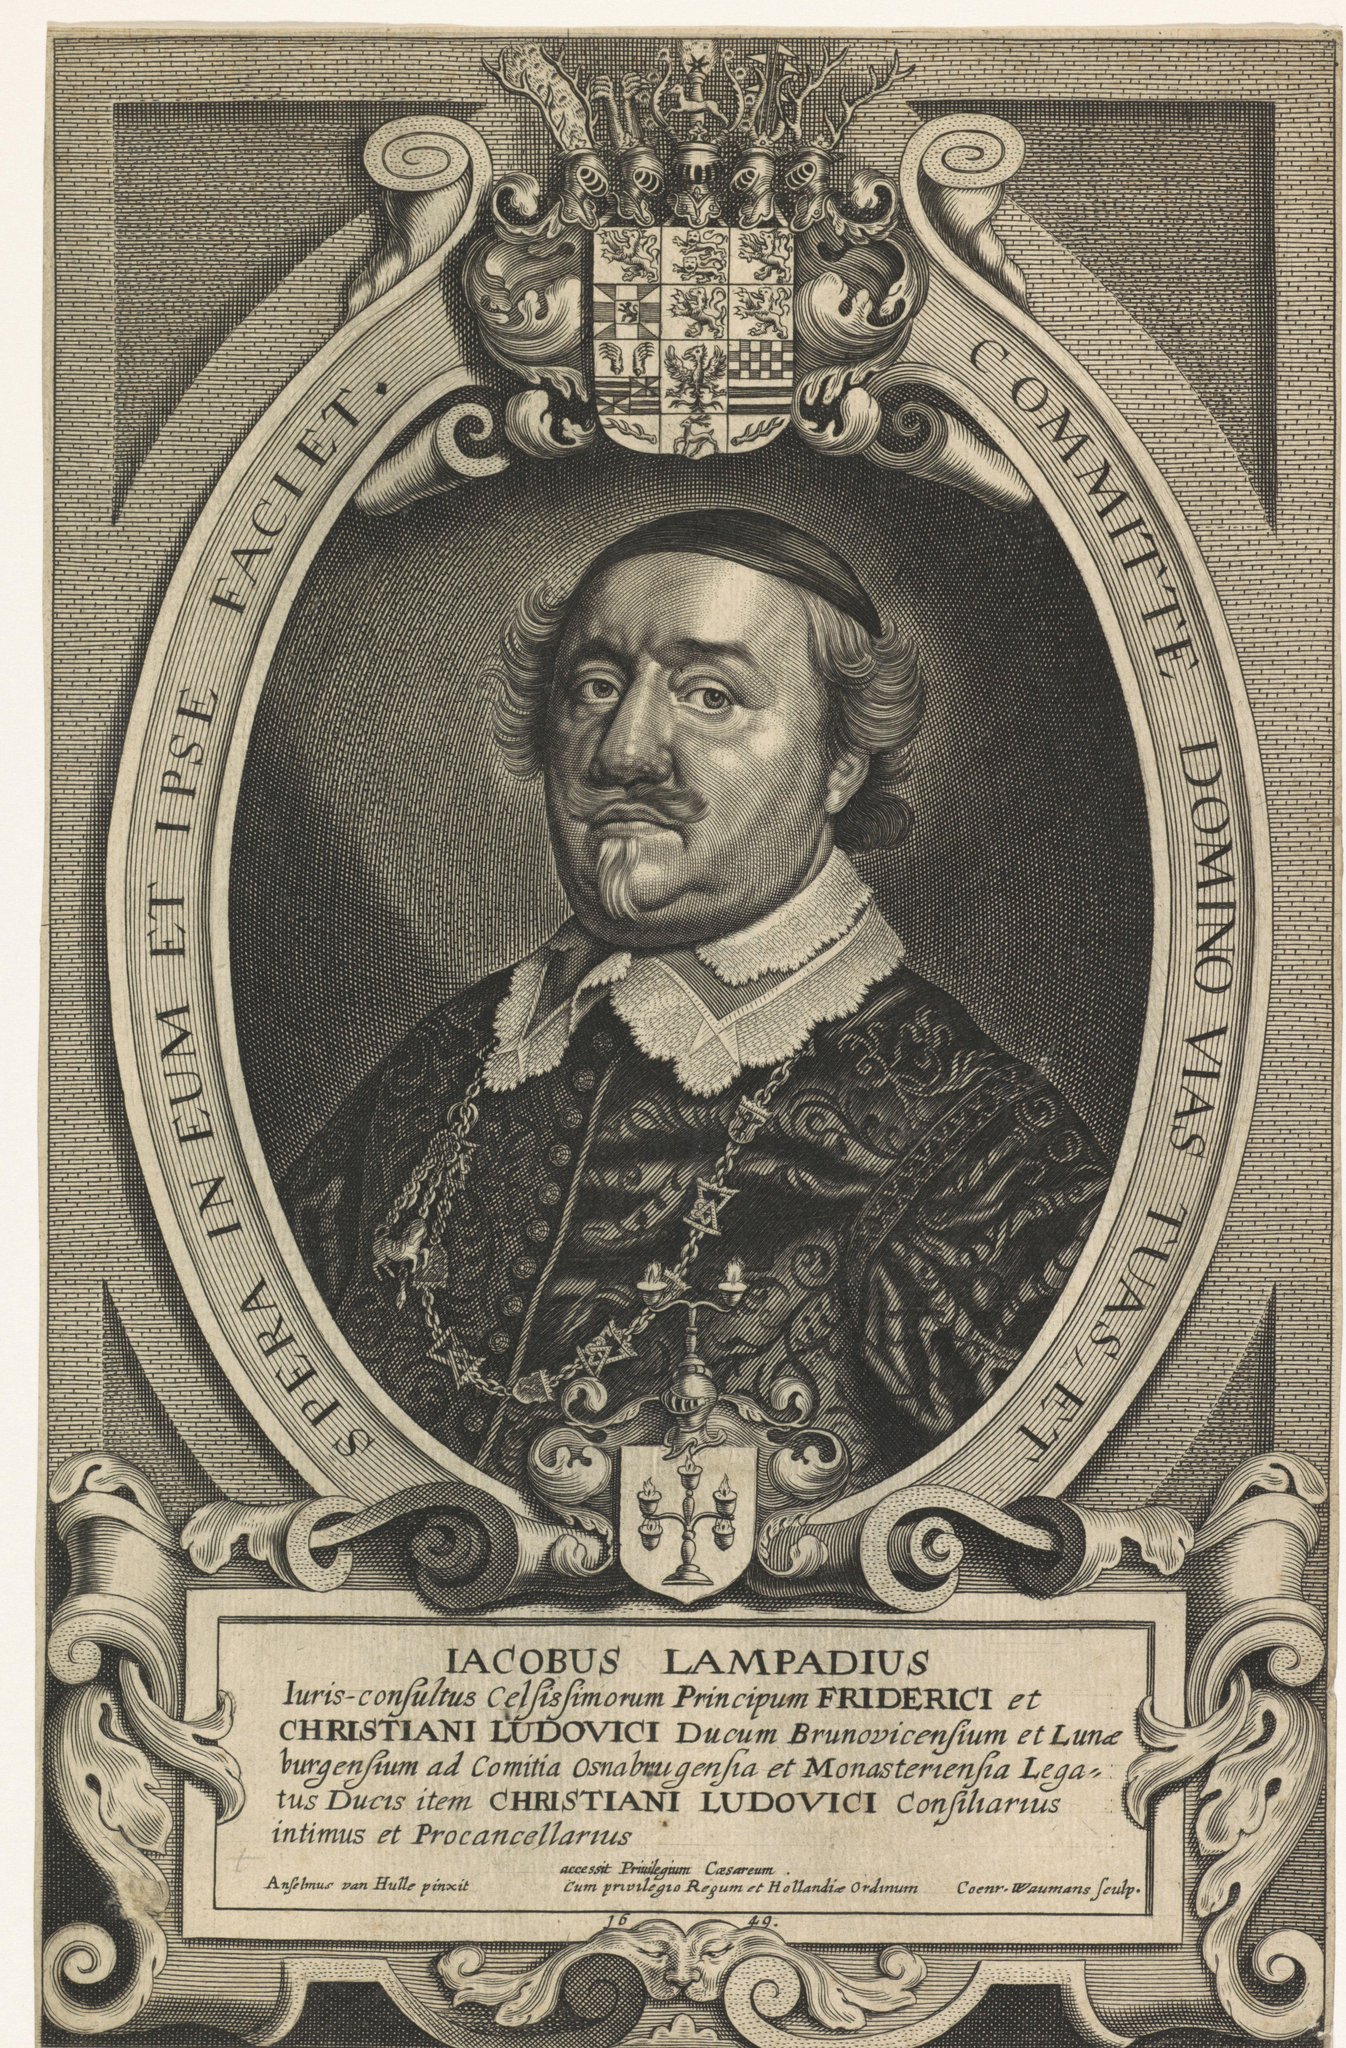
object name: print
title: Portret van Jacob Lampadius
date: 1649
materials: paper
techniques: engraving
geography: antwerp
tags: armorial bearing, heraldry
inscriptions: collector's mark: Lugt 2228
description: Portret van Jacob Lampadius, in een ovale omlijsting met een randschrift in het Latijn, bekroond met een wapenschild. In het kader een zesregelig onderschrift in het Latijn.